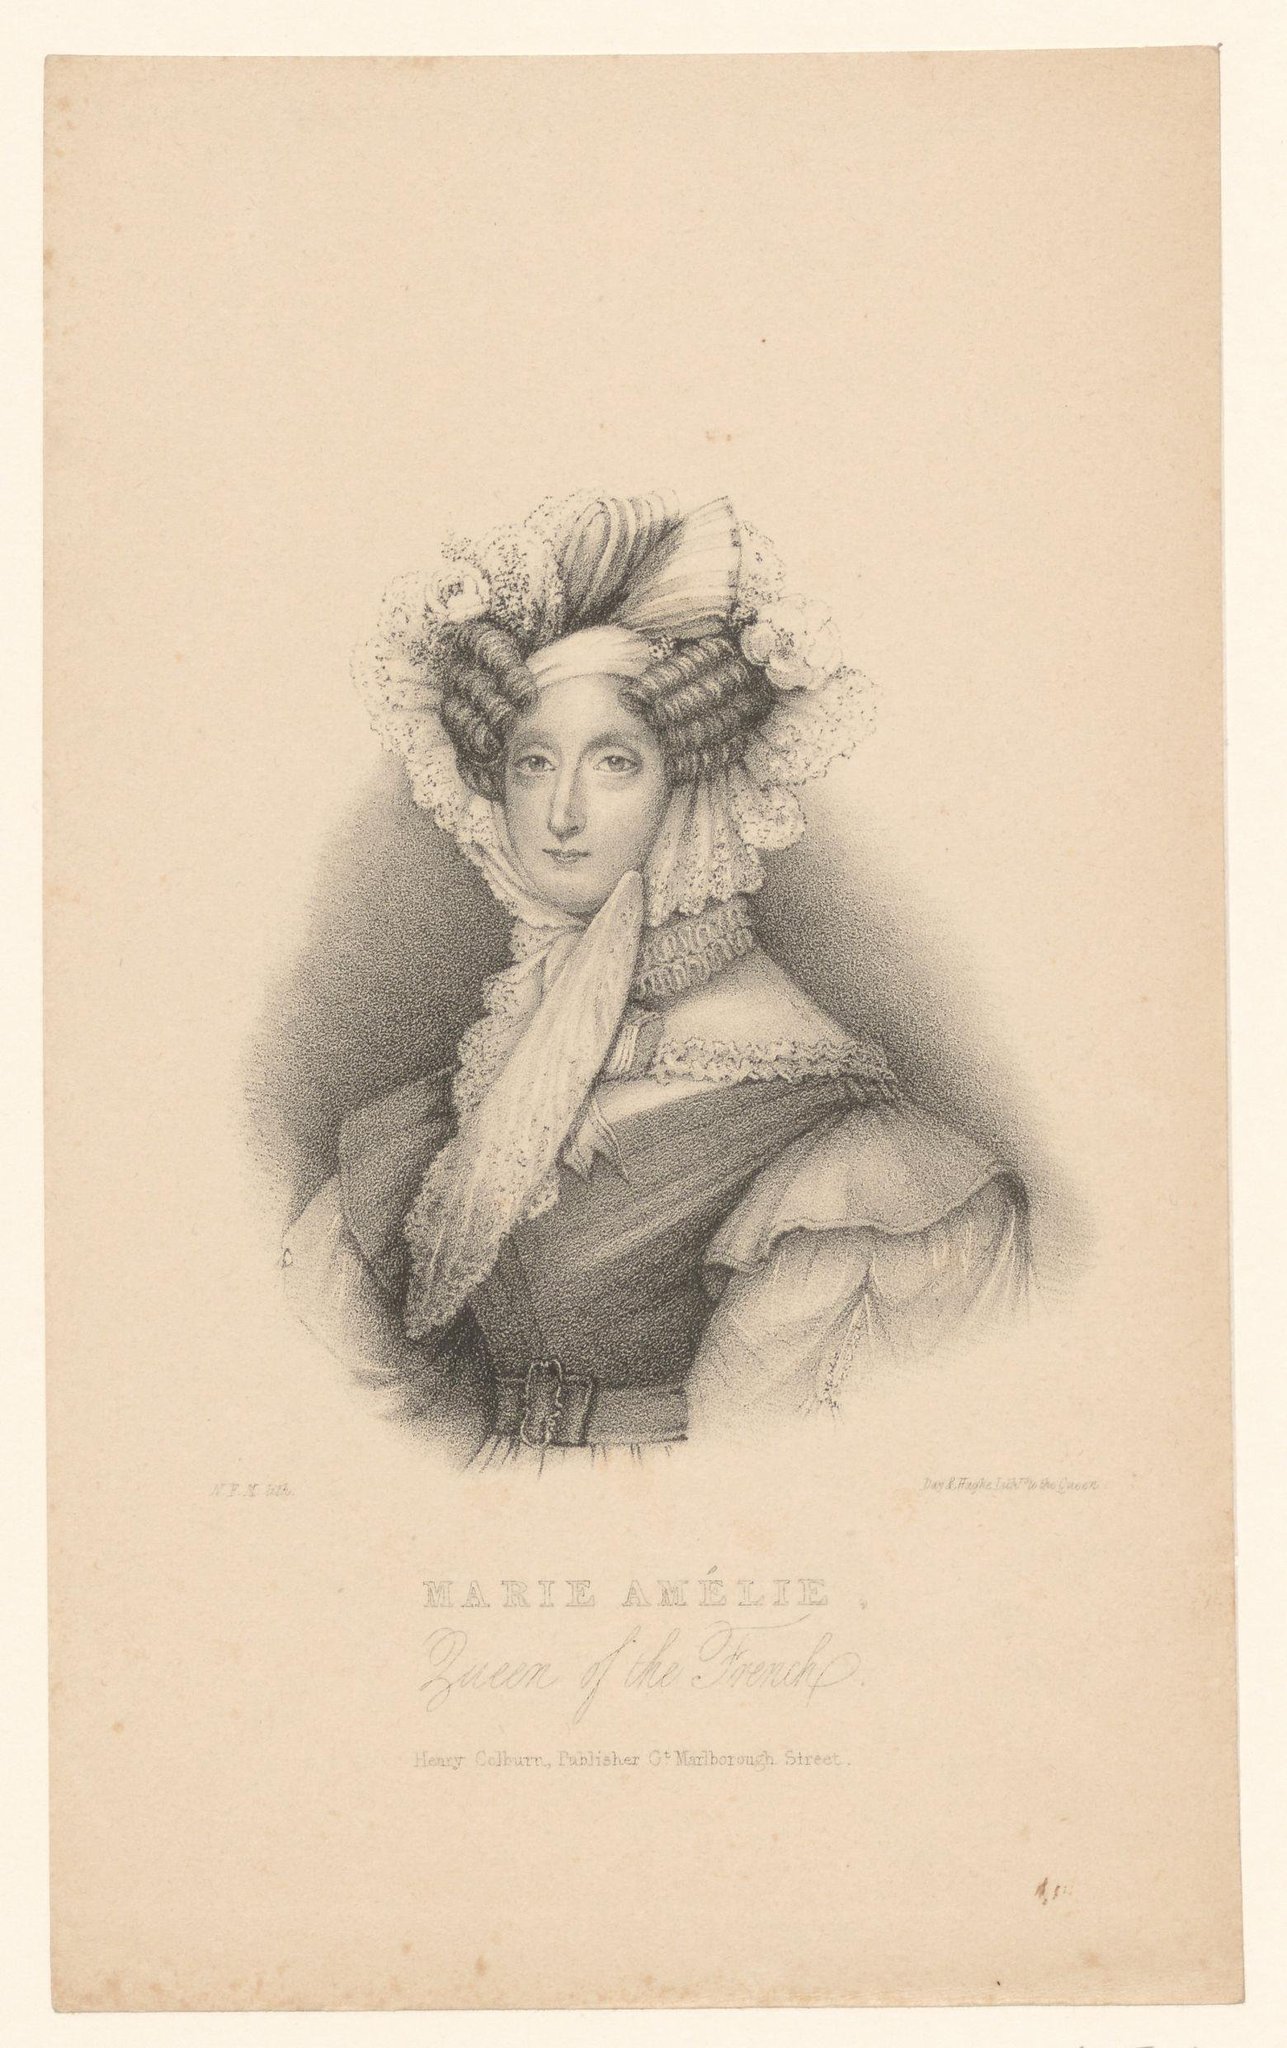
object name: print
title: Portret van Marie Amélie van Bourbon-Sicilië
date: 1820-1875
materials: paper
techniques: lithograph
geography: london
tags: caserta, london, adult woman, head-gear, historical persons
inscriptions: collector's mark: Lugt 2228